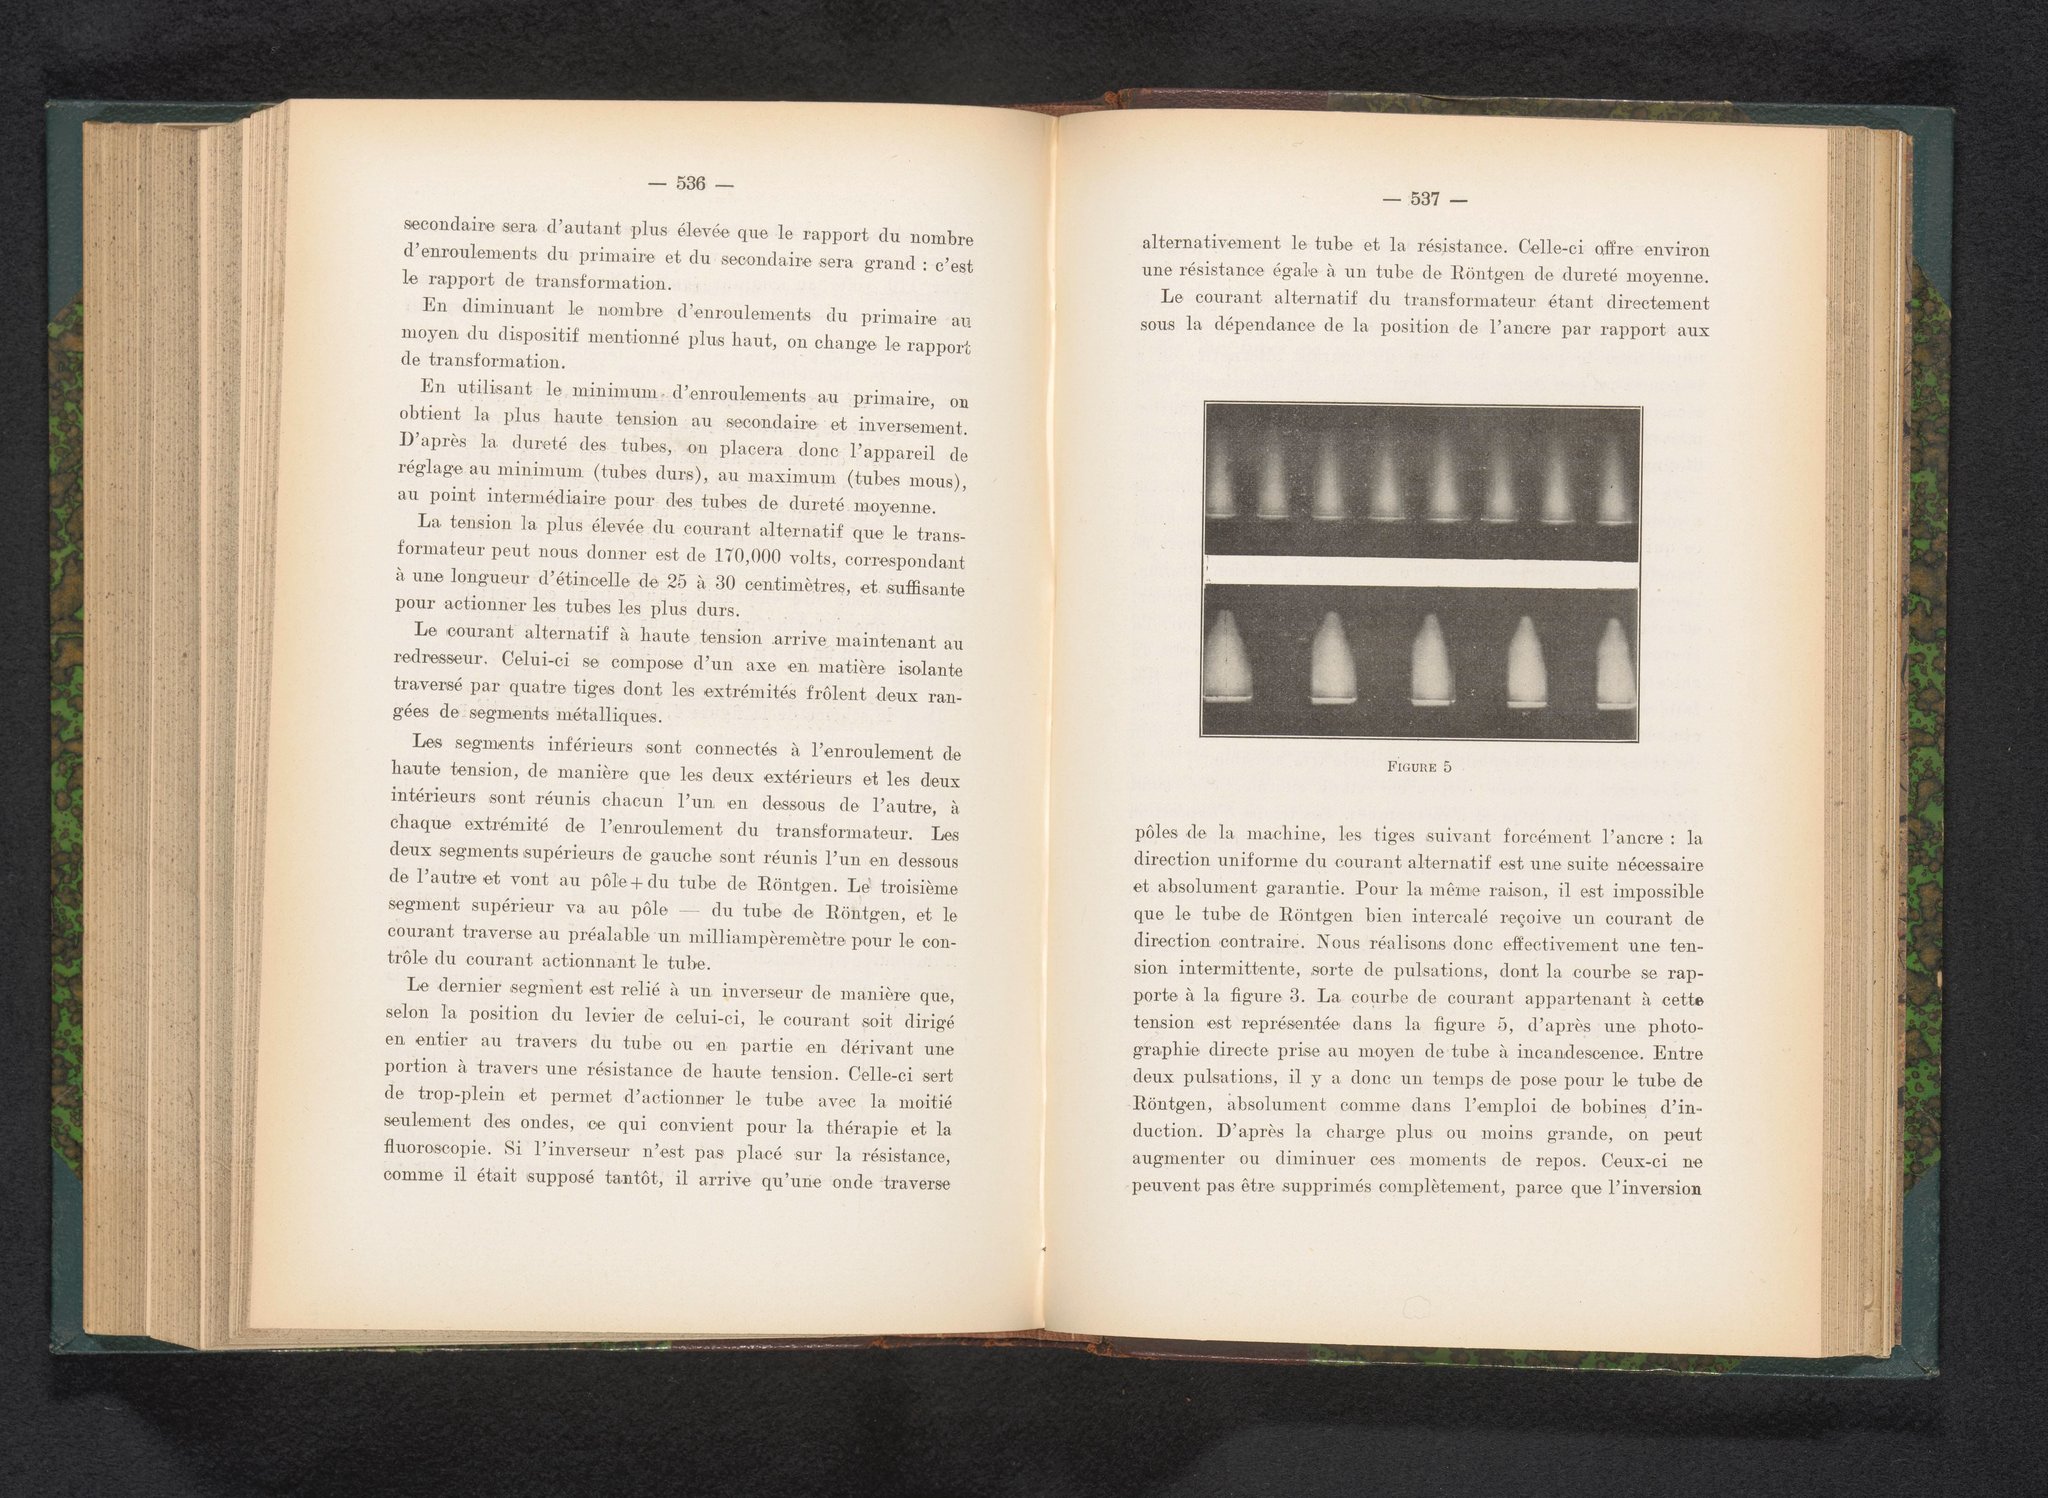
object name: photomechanical print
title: Pulsering van röntgenstraling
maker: Anonymous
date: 1904-1909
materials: paper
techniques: autotype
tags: electrical phenomena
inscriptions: inscription: ‘Figure 5’